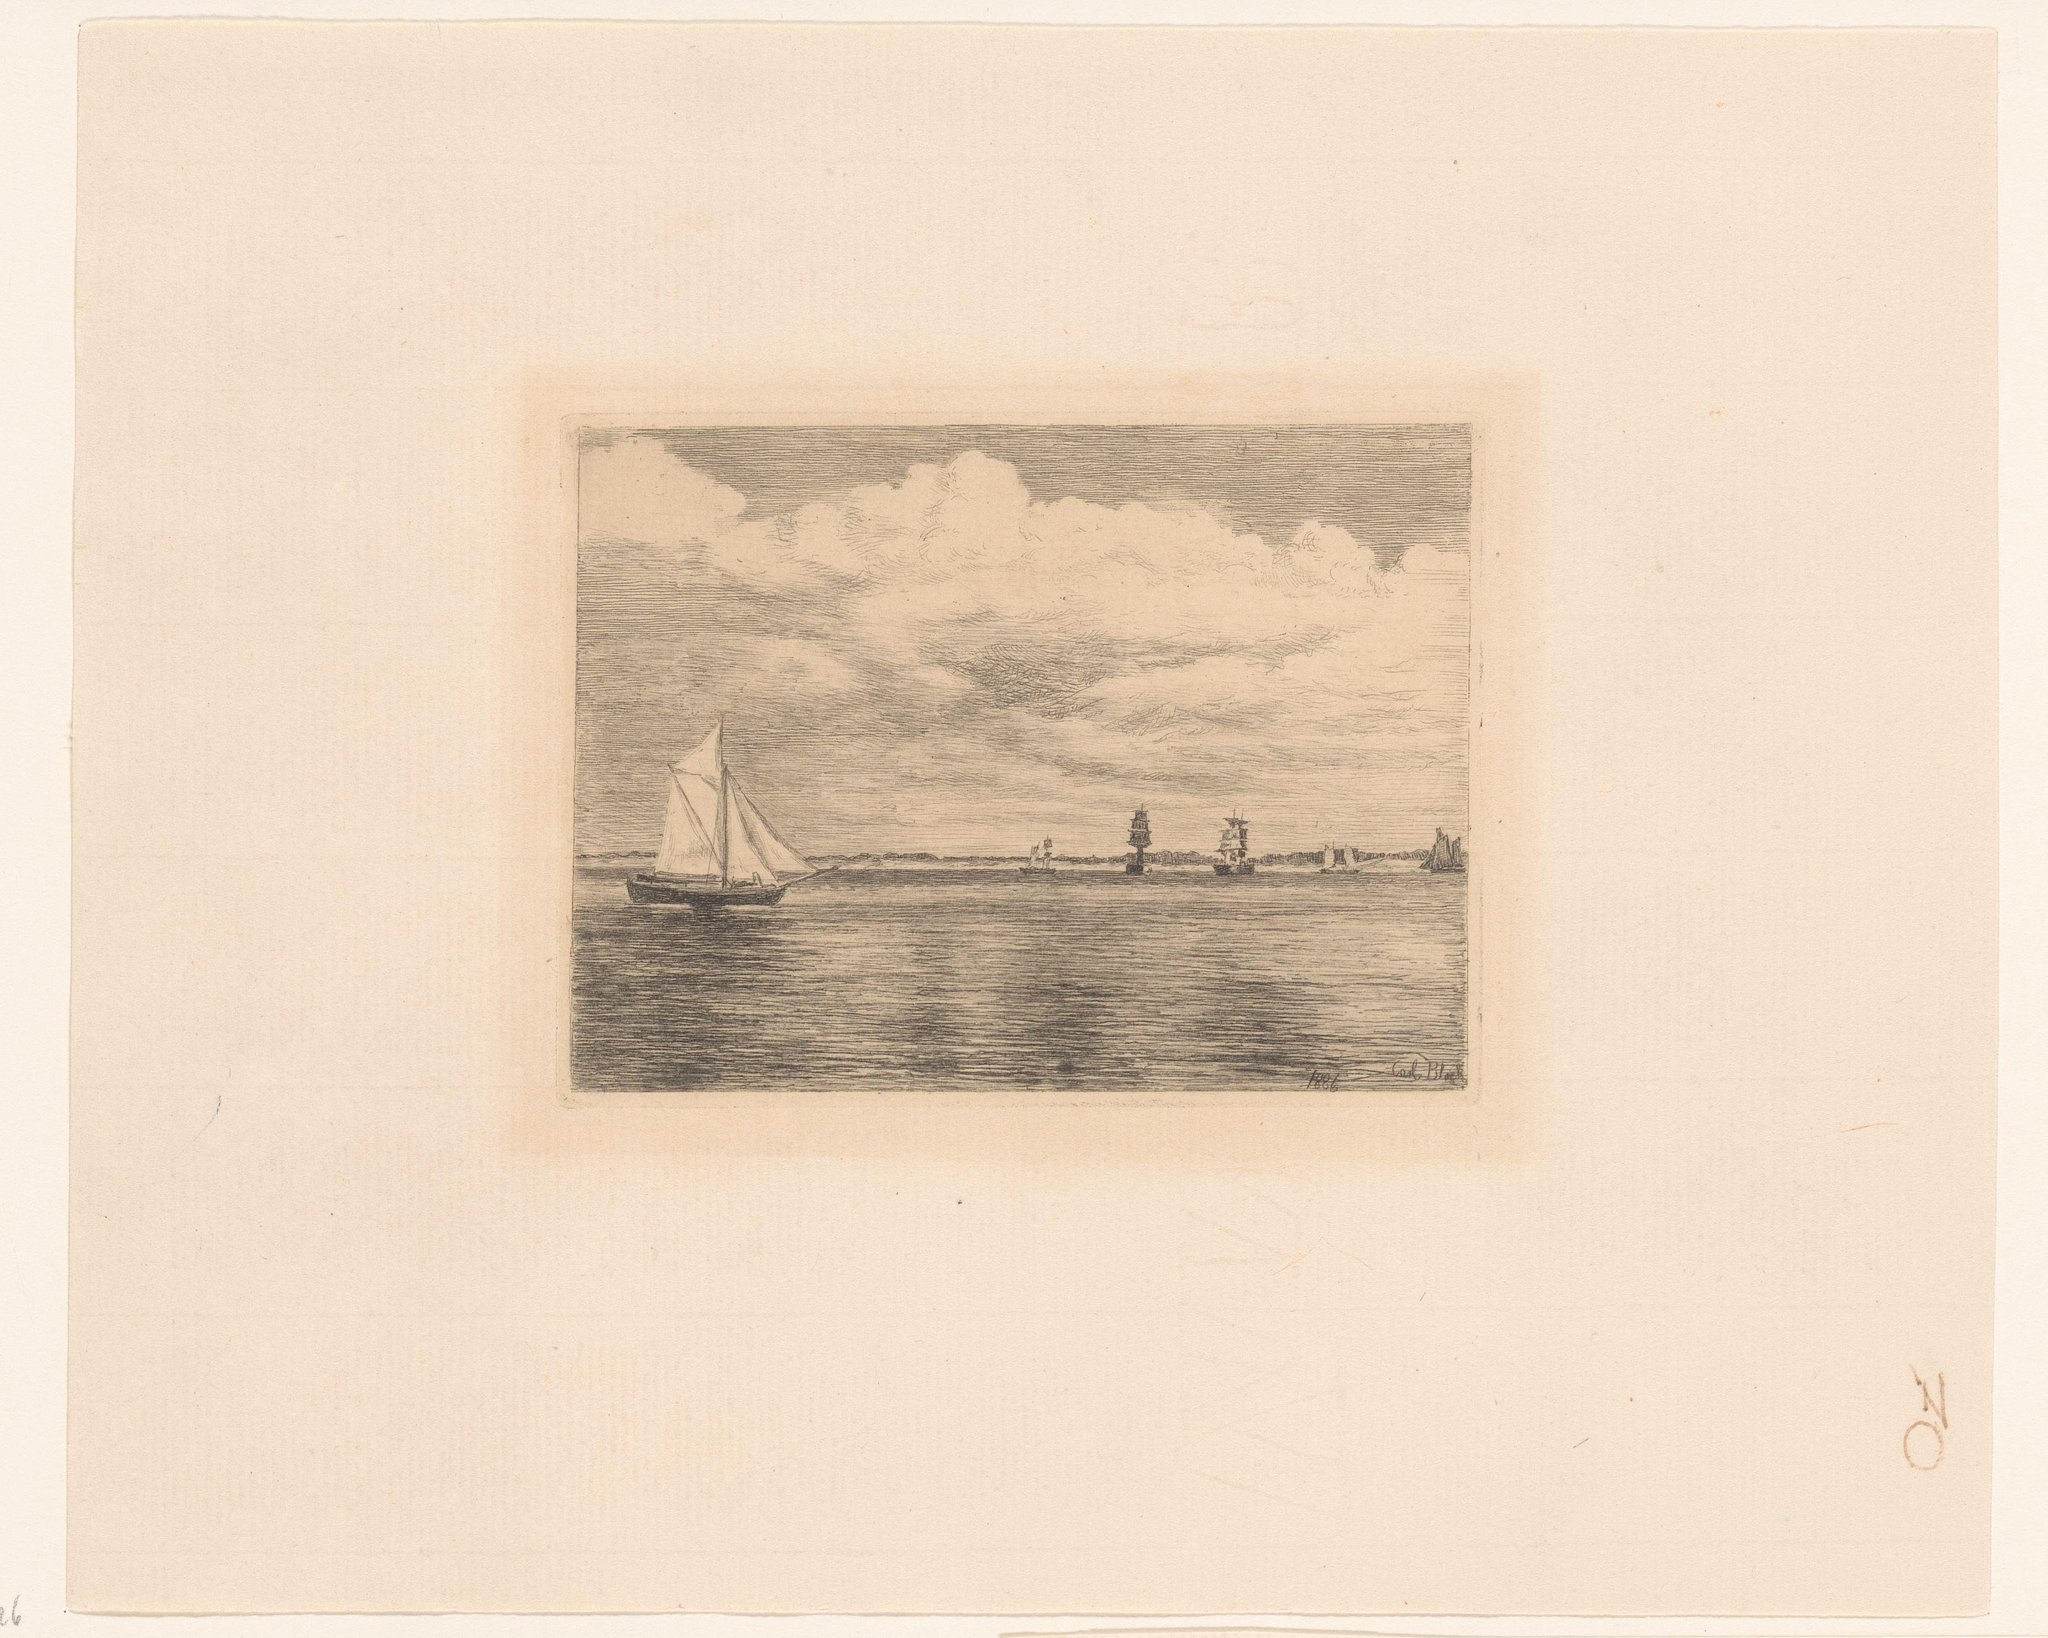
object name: print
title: Zeilboot onder wolkenlucht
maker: carl bloch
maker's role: print maker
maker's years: 1834-1890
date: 1886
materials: paper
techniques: drypoint, etching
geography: scandinavia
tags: sailing-ship, sailing-boat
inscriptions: collector's mark: Lugt 2228, signature and date: ‘r.o. gesigneerd en gedateerd Carl Bloch 1886’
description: Zeilboot op een plas, onder laaghangende wolkenlucht. Op de achtergrond andere zeilboten.